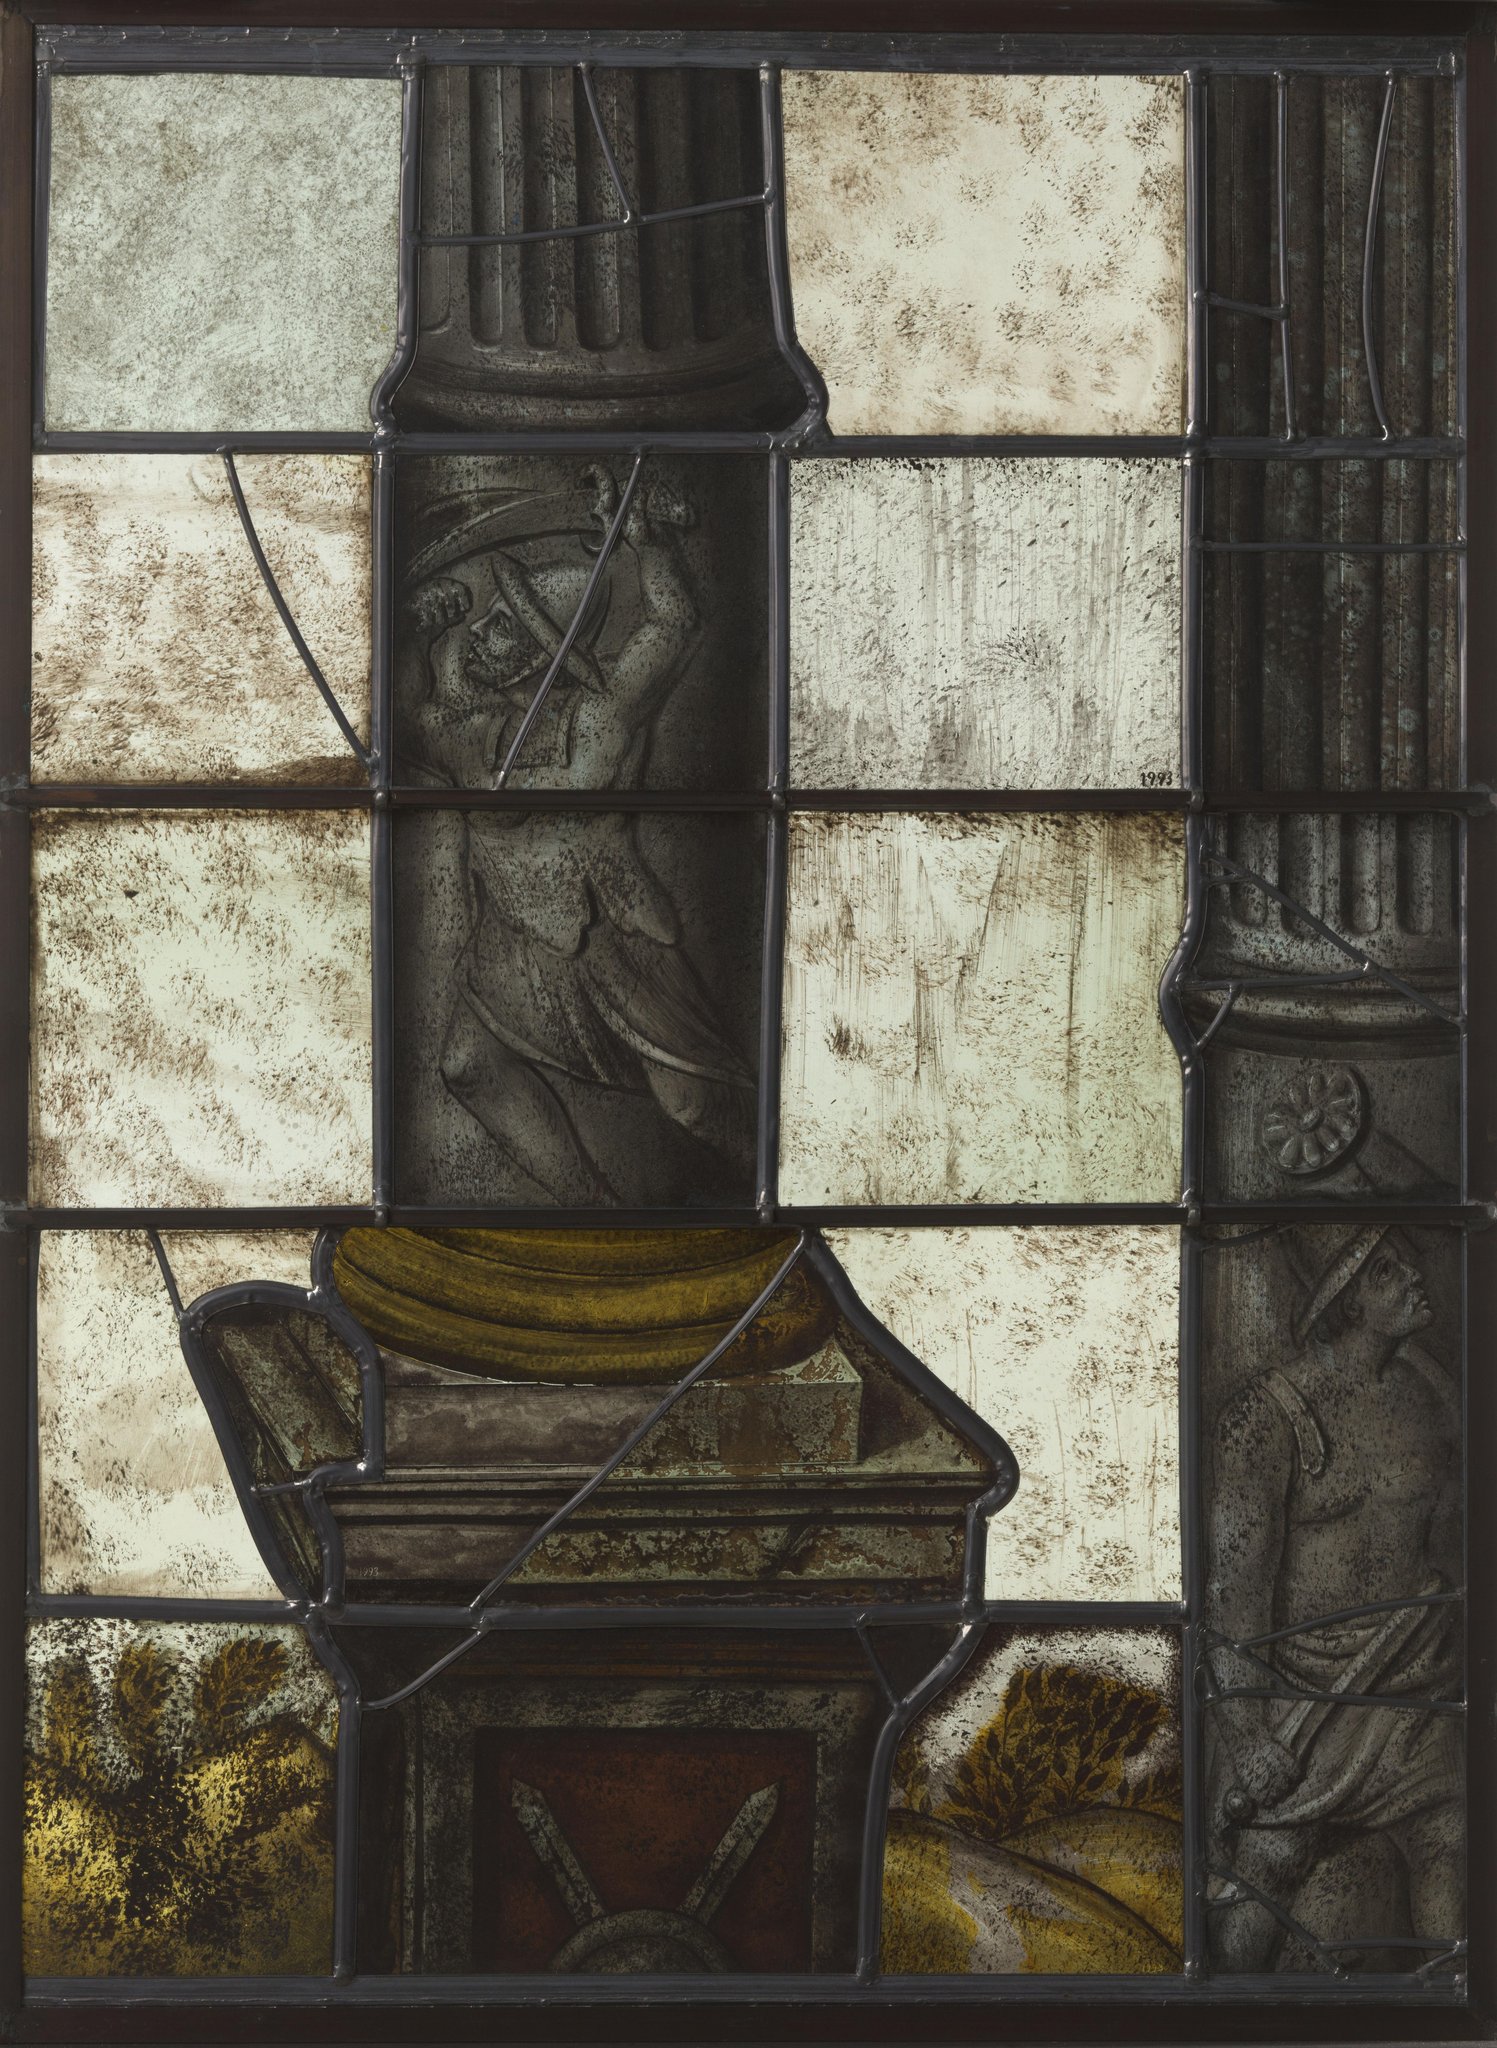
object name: light window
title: Zesde paneel van ruit met Prins Maurits in biddende houding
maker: Anonymous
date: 1618-1620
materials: glass, lead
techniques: leading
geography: netherlands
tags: the hague, maurice (prince of orange)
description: Groot raam afkomstig uit het klooster van St Agatha bij Cuyk. Prins Maurits in verguld harnas, met hermelijnen mantel en geplooide kraag, blootshoofds, in biddende houding, geknield op een bidstoel voor een lessenaar waarop een boek. De lessenaar staat op een tafel met een donkerblauw kleed met gouden franje gedekt. Helm en handschoenen liggen op de grond voor de tafel. De prins bevindt zich in een koepel door vier vrijstaande Korintische zuilen gedragen; boven zijn hoofd een baldakijn waaruit een lauwerkrans afhangt. De koepel wordt bekroond door het wapen van Maurits en het devies van de Orde van de Kousenband: 'Honi soit qui mal y pense' (Schande over hem die er kwaad van denkt). Wapen door twee lopende jongelingen gesteund. Het wapen leunt tegen het bovenstuk van de koepel. Onder dit tafereel bevinden zich brokstukken architectuur die onoordeelkundig zijn aangebracht. Rechts ligt een jonge vrouw geknield met opgeheven handen. Zij draagt een geel zijden mantel met hermelijn omzoomd. Het gezicht is in olieverf bijgemaakt in 1891.